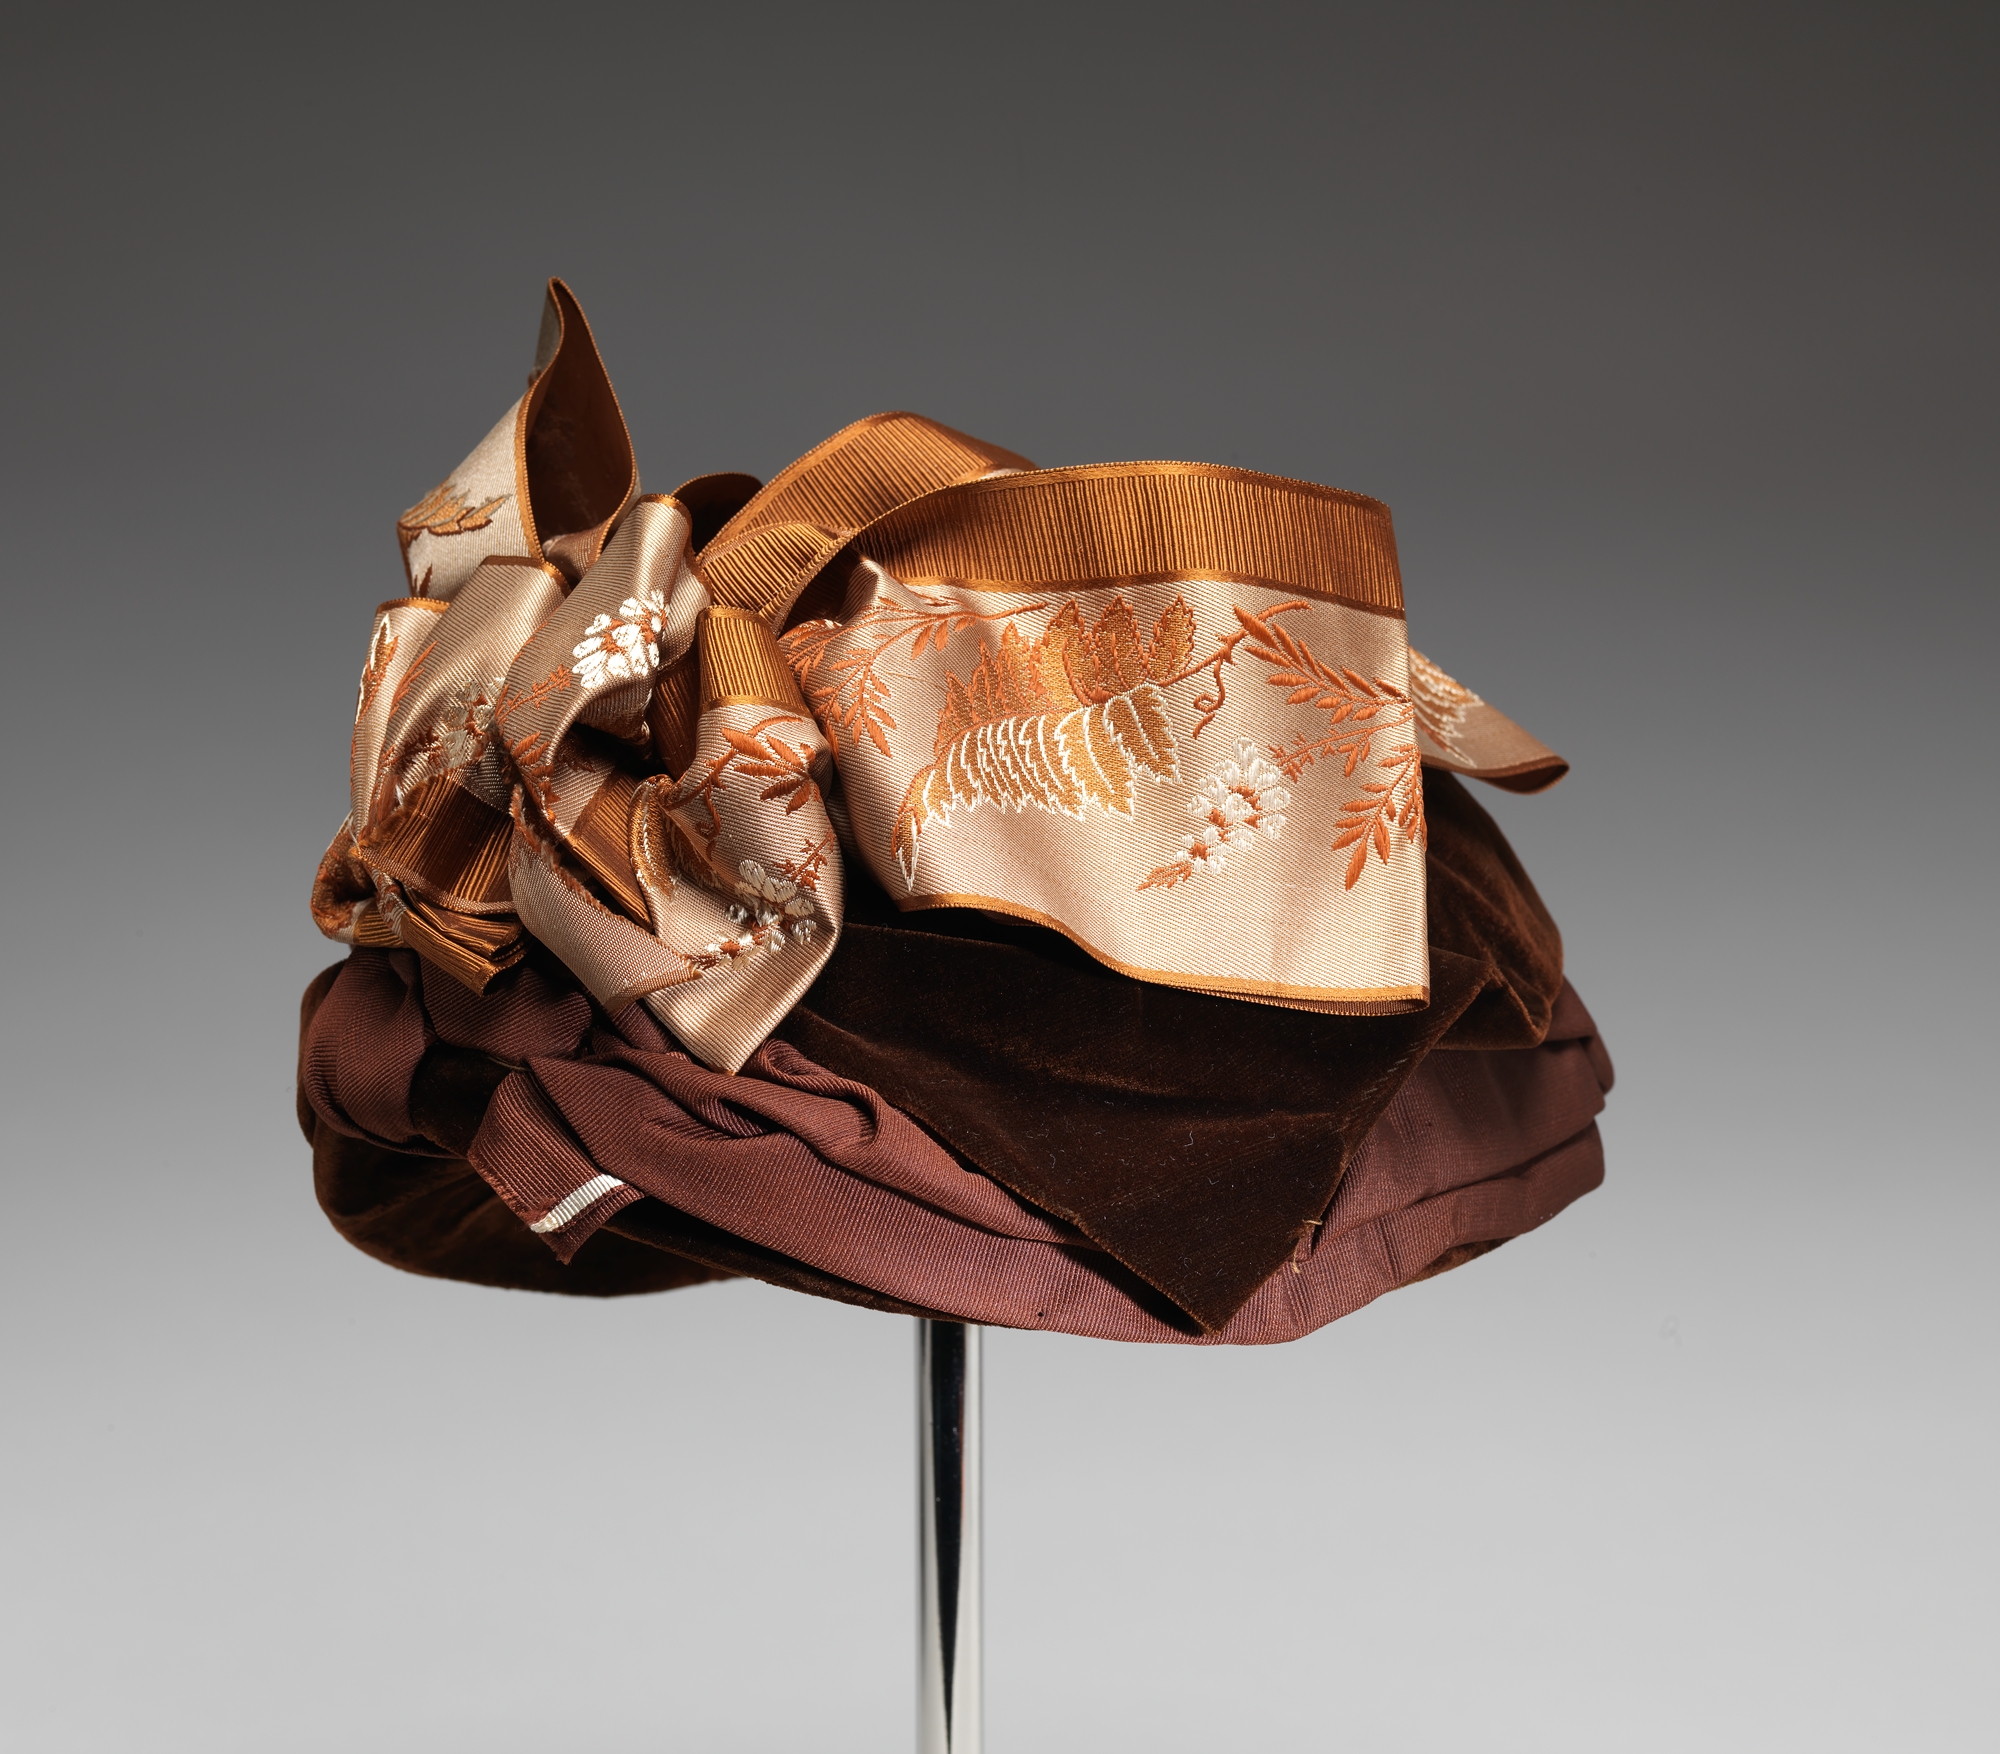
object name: hat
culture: american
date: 1885-1899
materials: silk